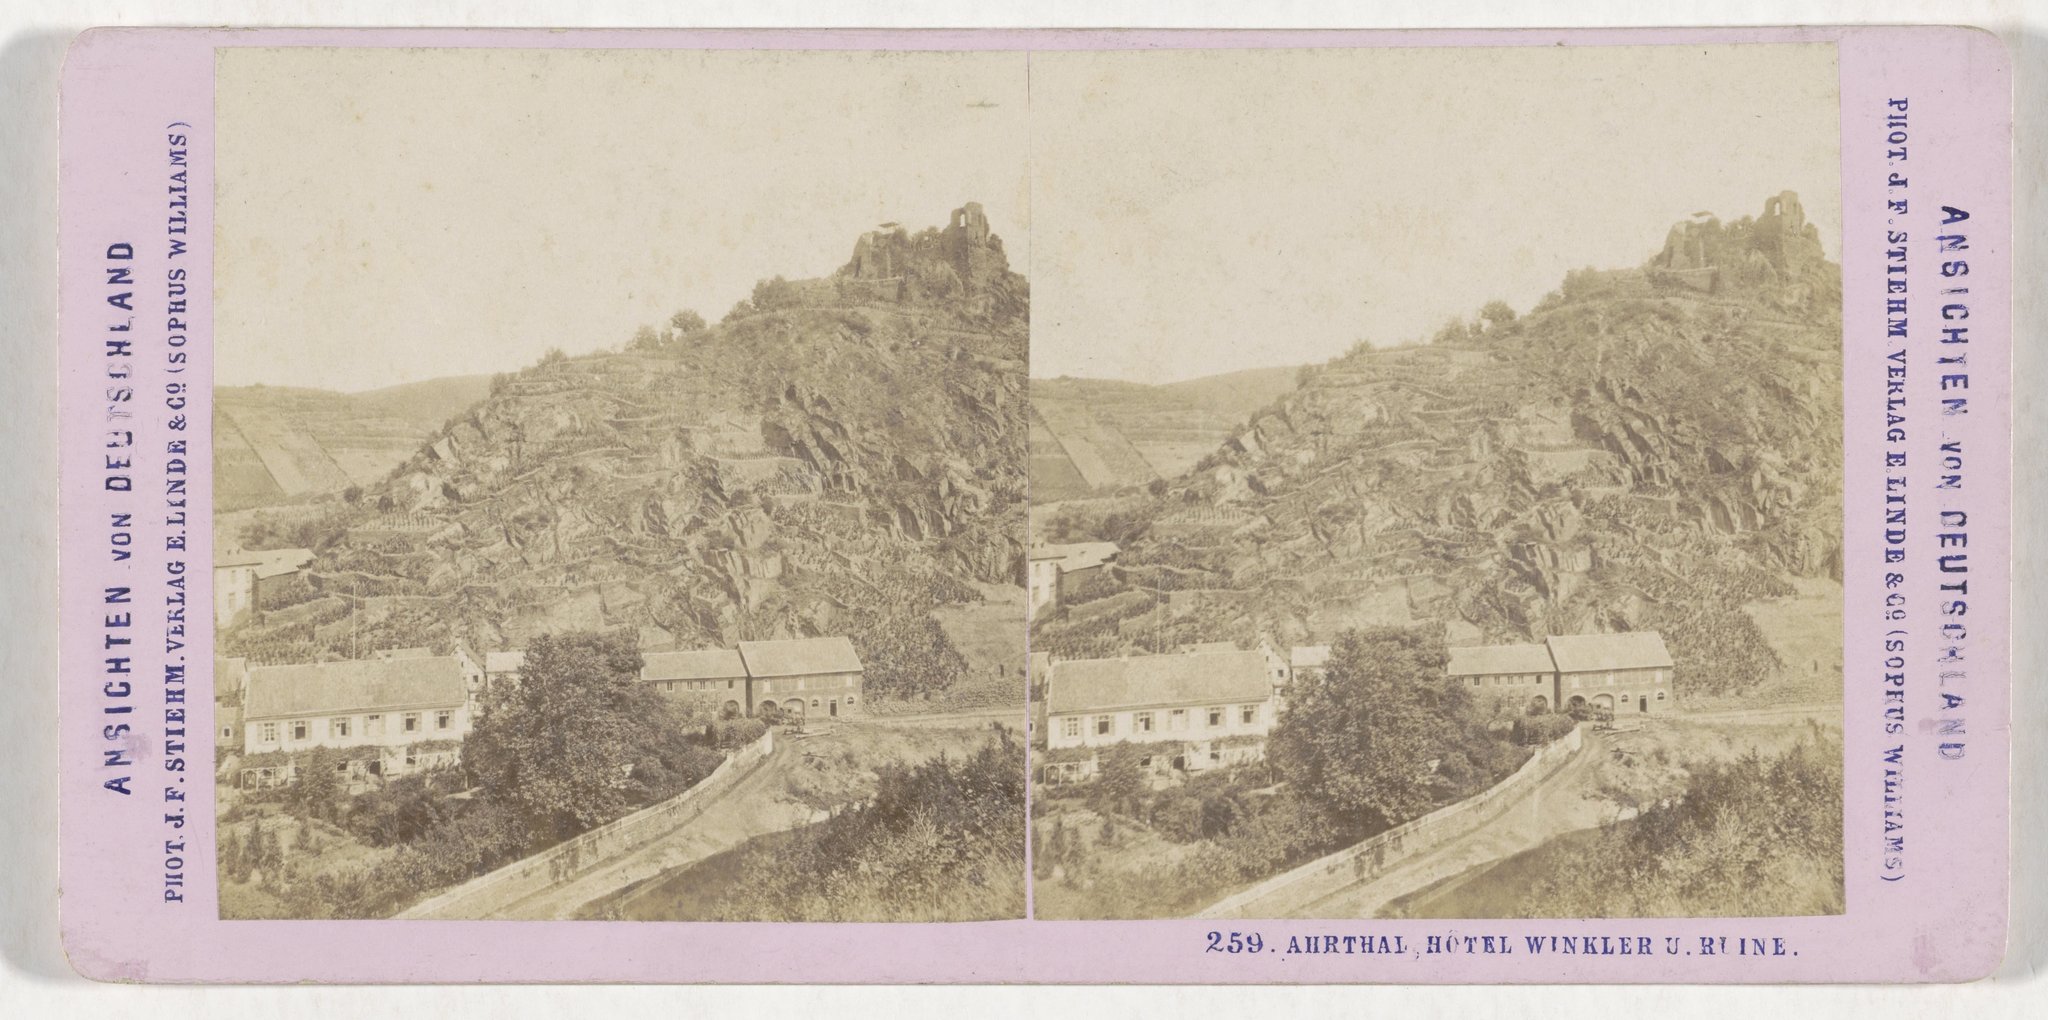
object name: stereograph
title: Ansichten von Deutschland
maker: johann friedrich stiehm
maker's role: fotograaf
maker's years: 1826-1902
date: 1869-1872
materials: cardboard, paper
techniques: albumen print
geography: berlin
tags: village, landscape with ruins, rock-formations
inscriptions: number: ‘259.’